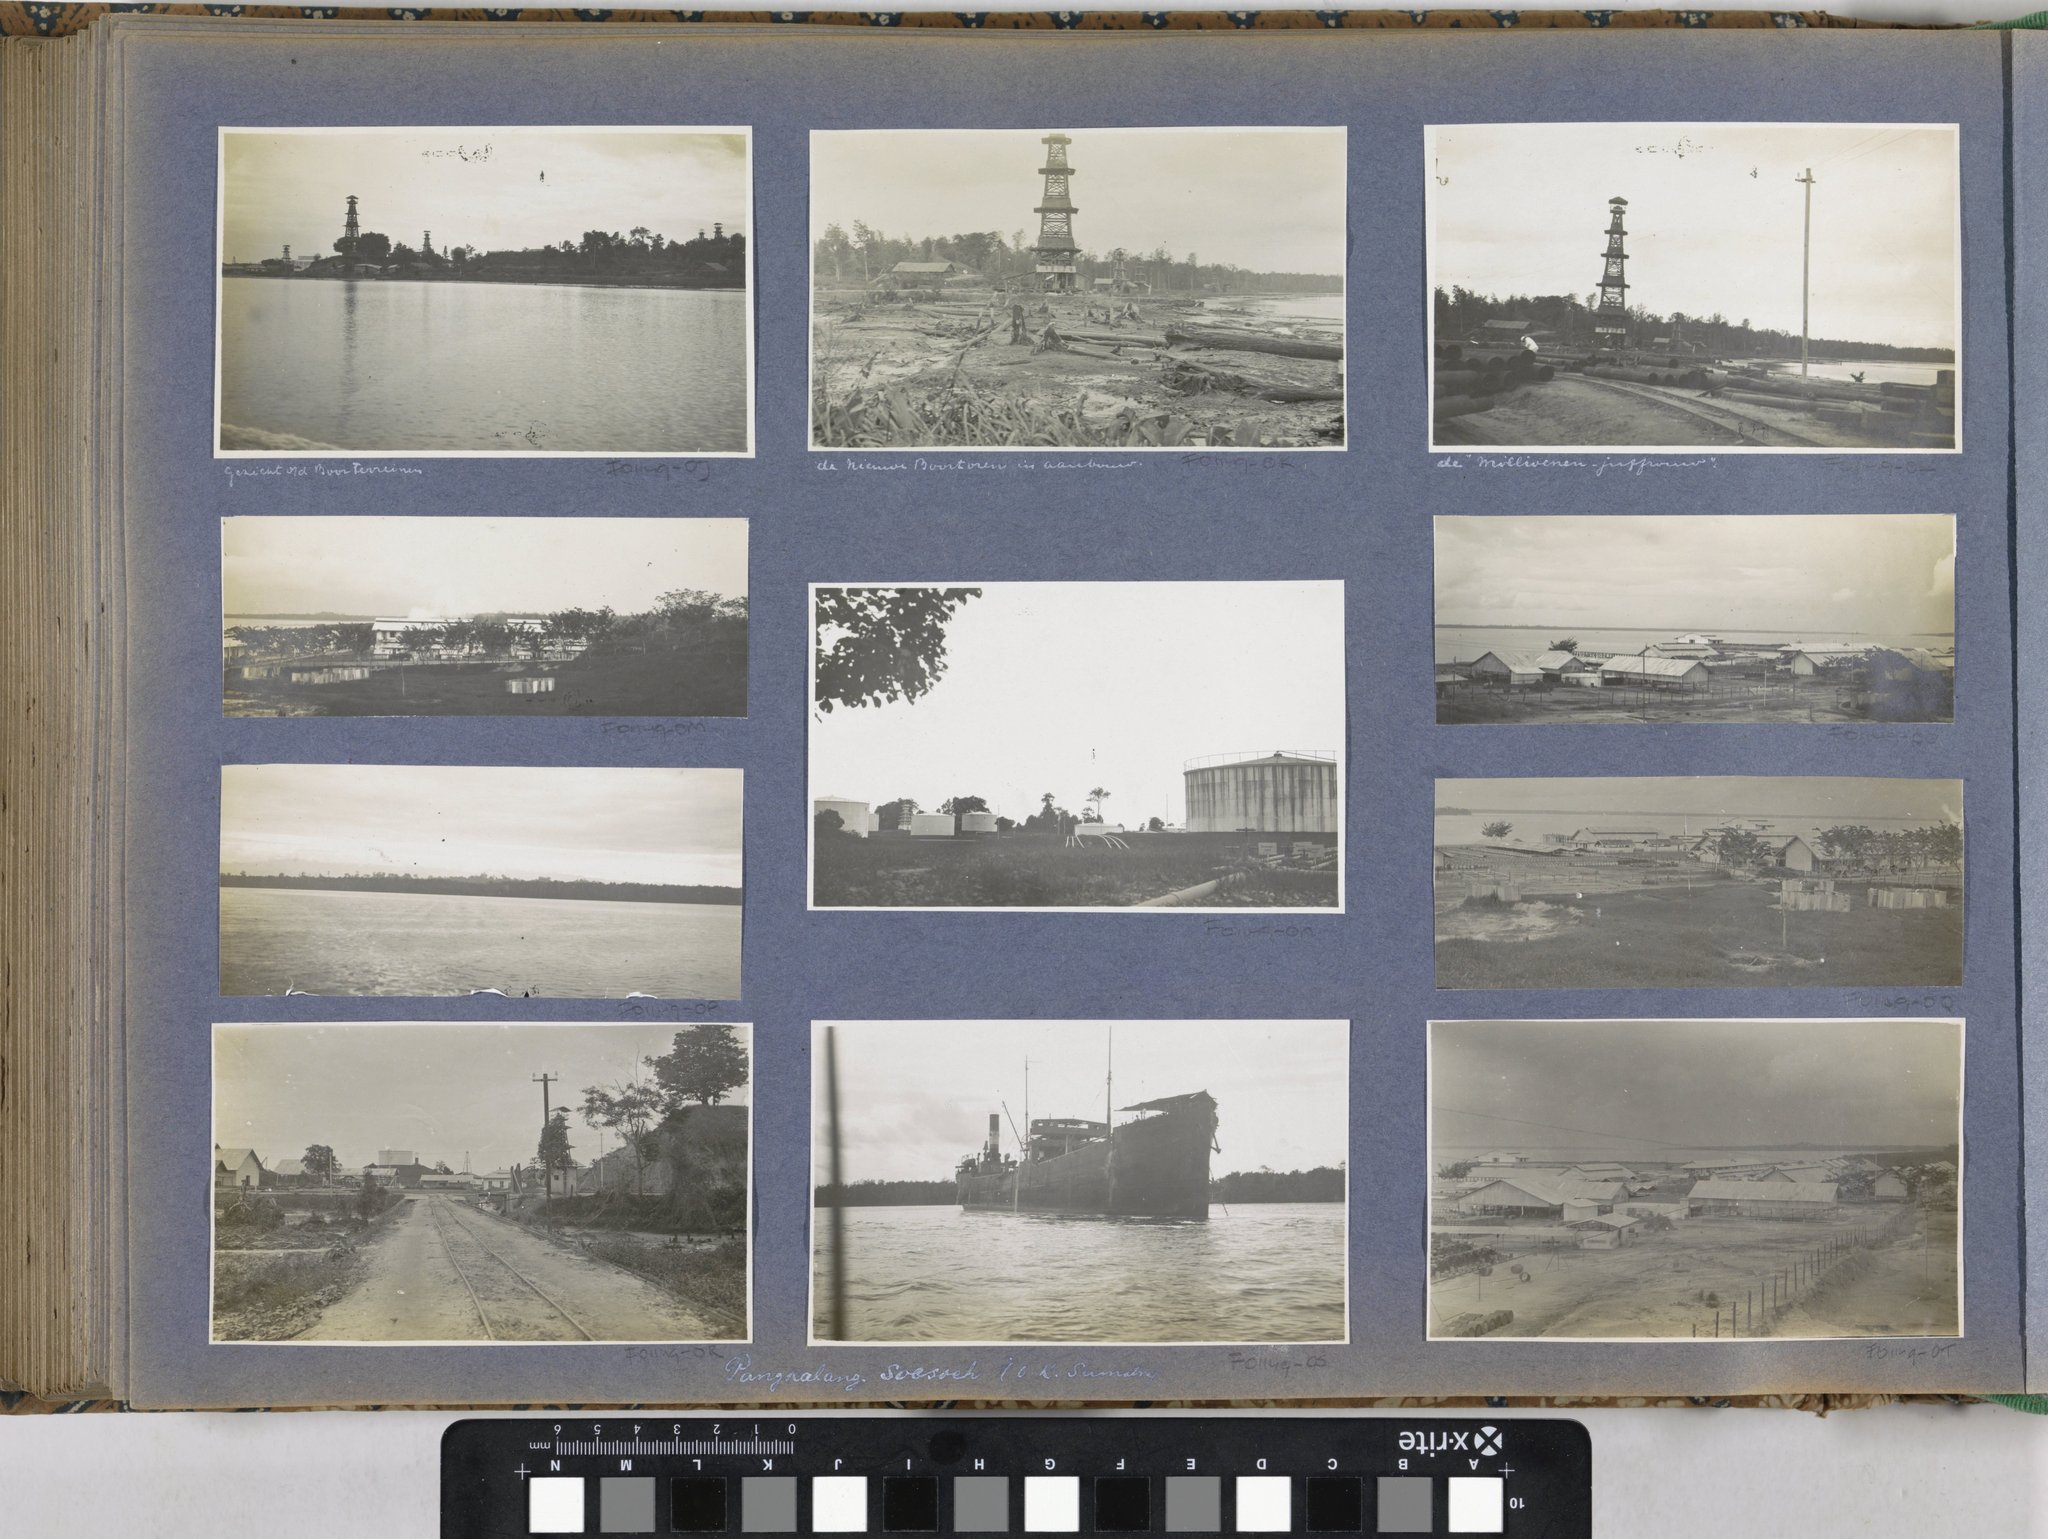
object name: photograph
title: Water met boortorens te Pangkalansusu op Sumatra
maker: Anonymous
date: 1900-1920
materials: paper, photographic support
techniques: gelatin silver print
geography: sumatra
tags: derrick ~ oil, oil; oil refinery, sumatra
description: Onderdeel van reisalbum met foto's van bedrijvigheid en bezienswaardigheden op Sumatra en Java en van de reis naar en van Nederlands-Indië.